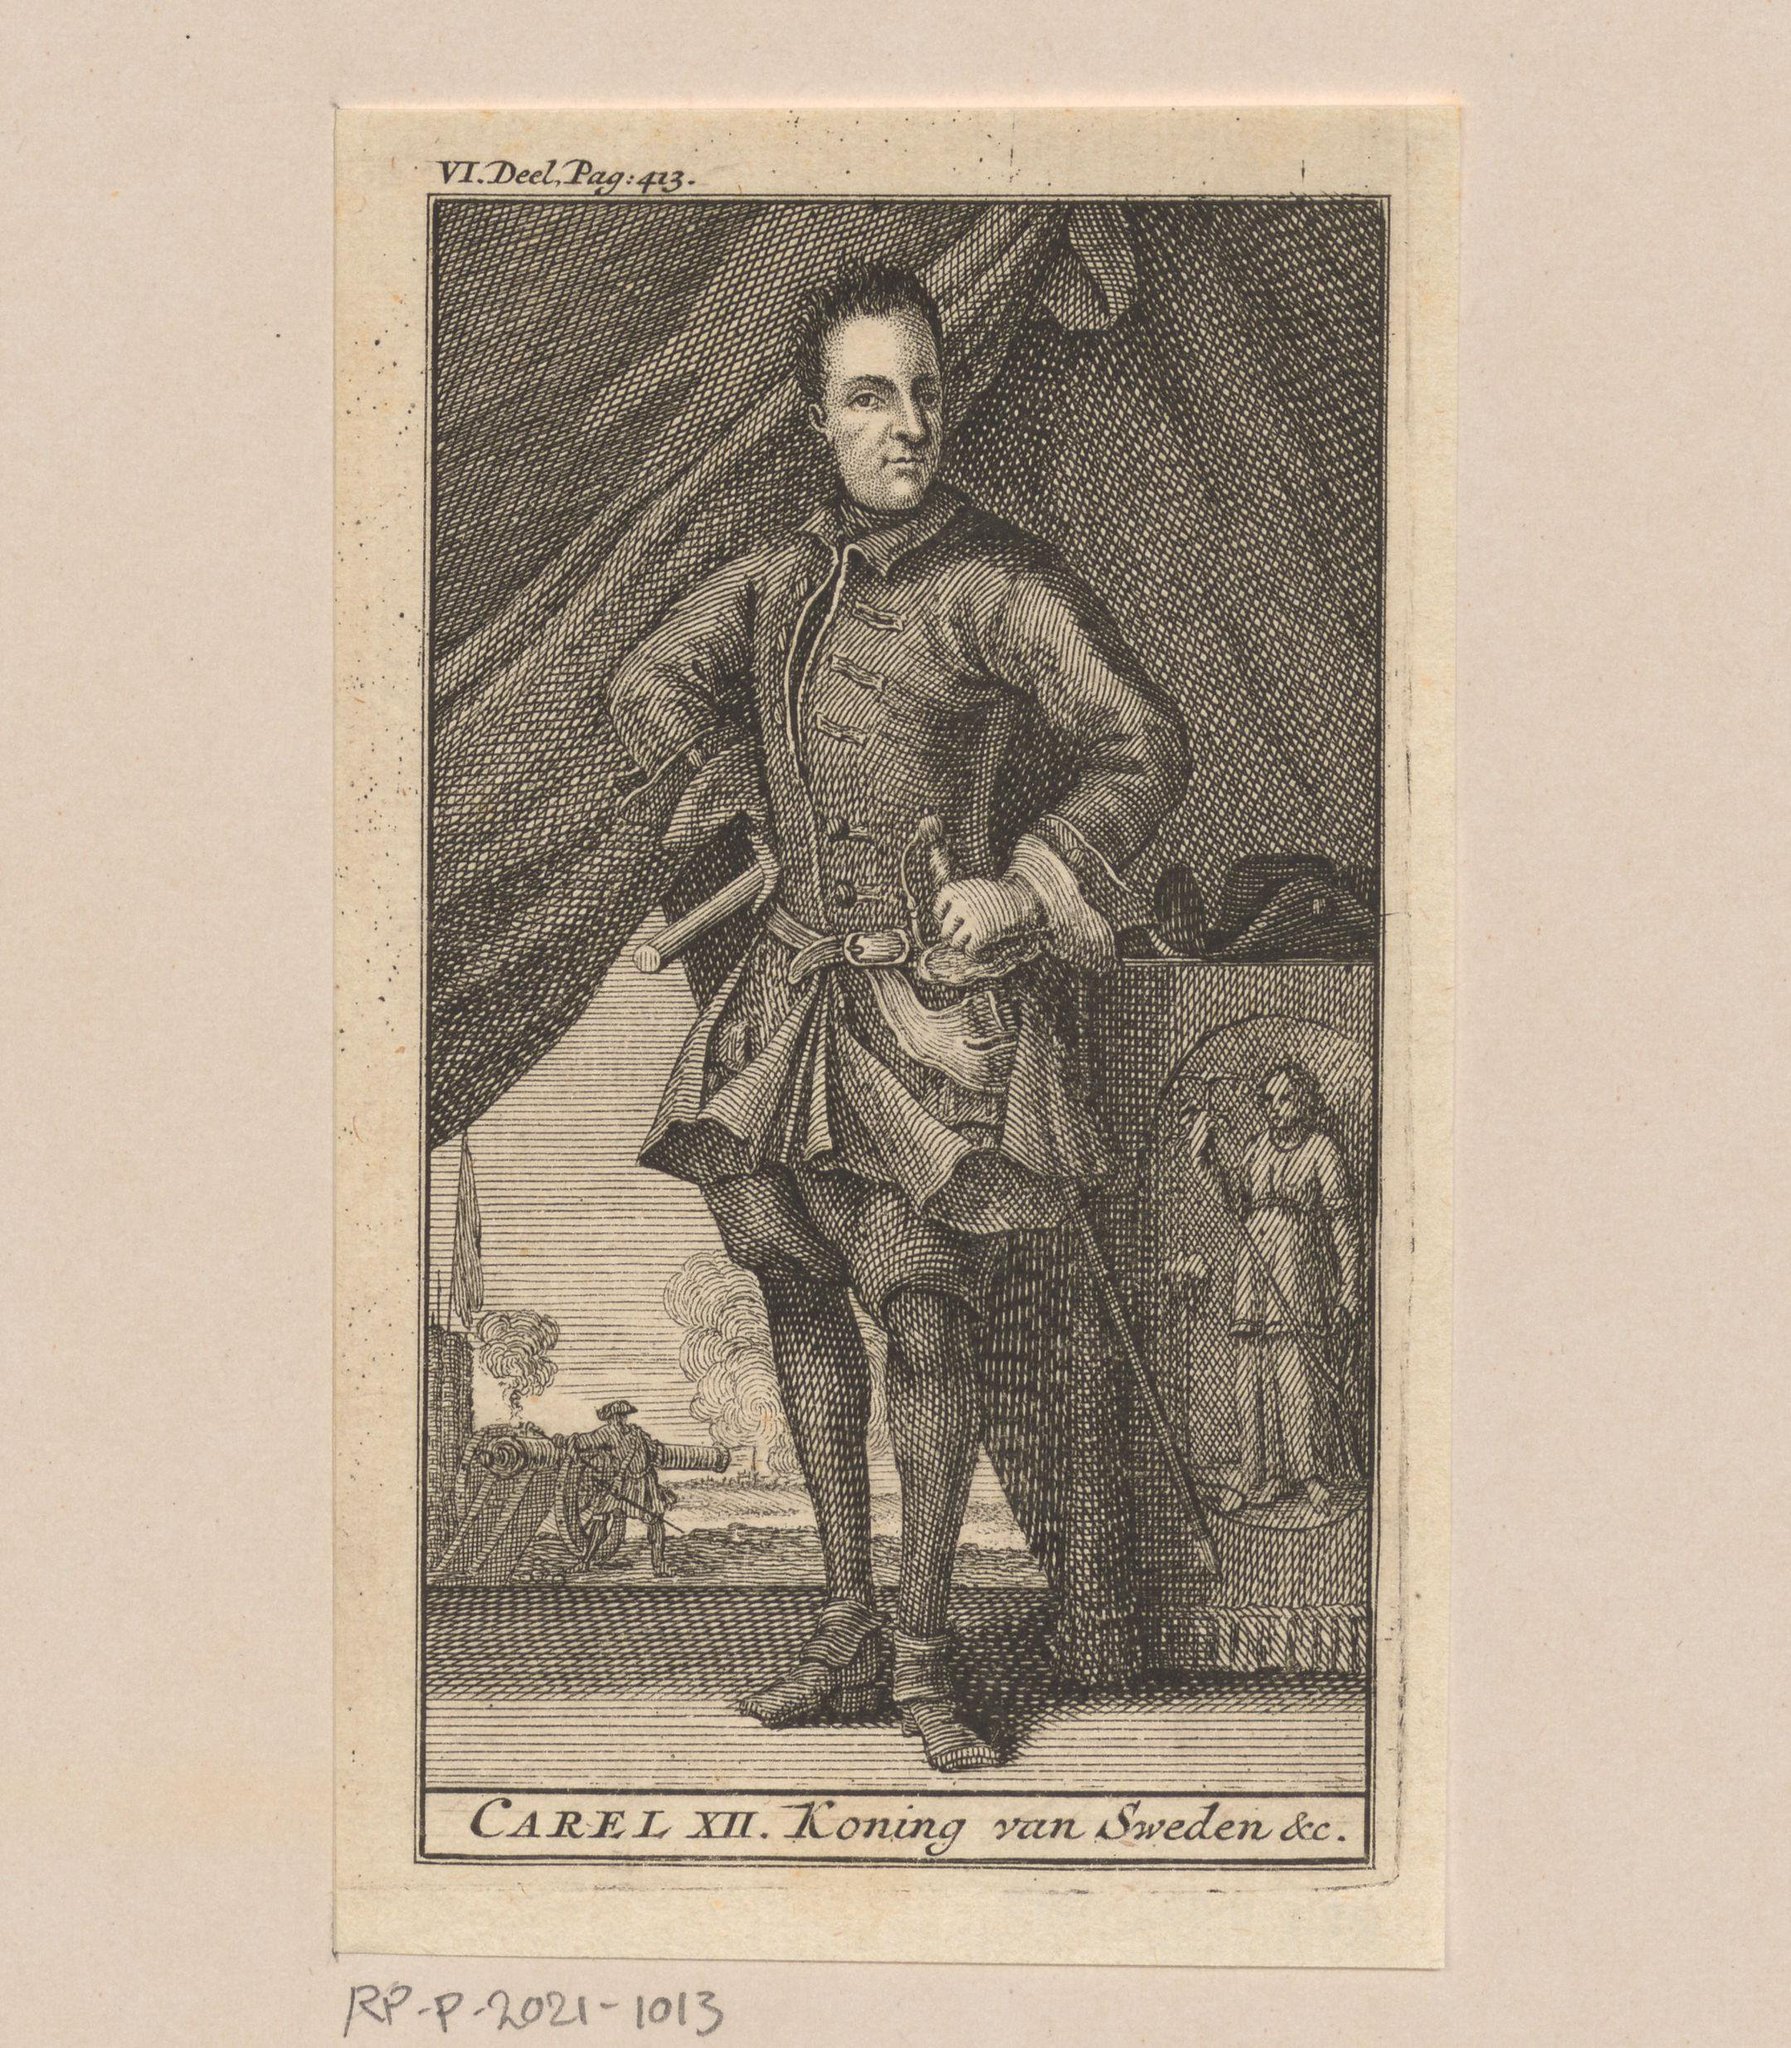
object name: print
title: Portret van Karel XII, koning van Zweden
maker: Anonymous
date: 1697-1749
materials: paper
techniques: engraving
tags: historical persons, firearms: cannon, king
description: Linksboven genummerd: VI. Deel, Pag: 413.